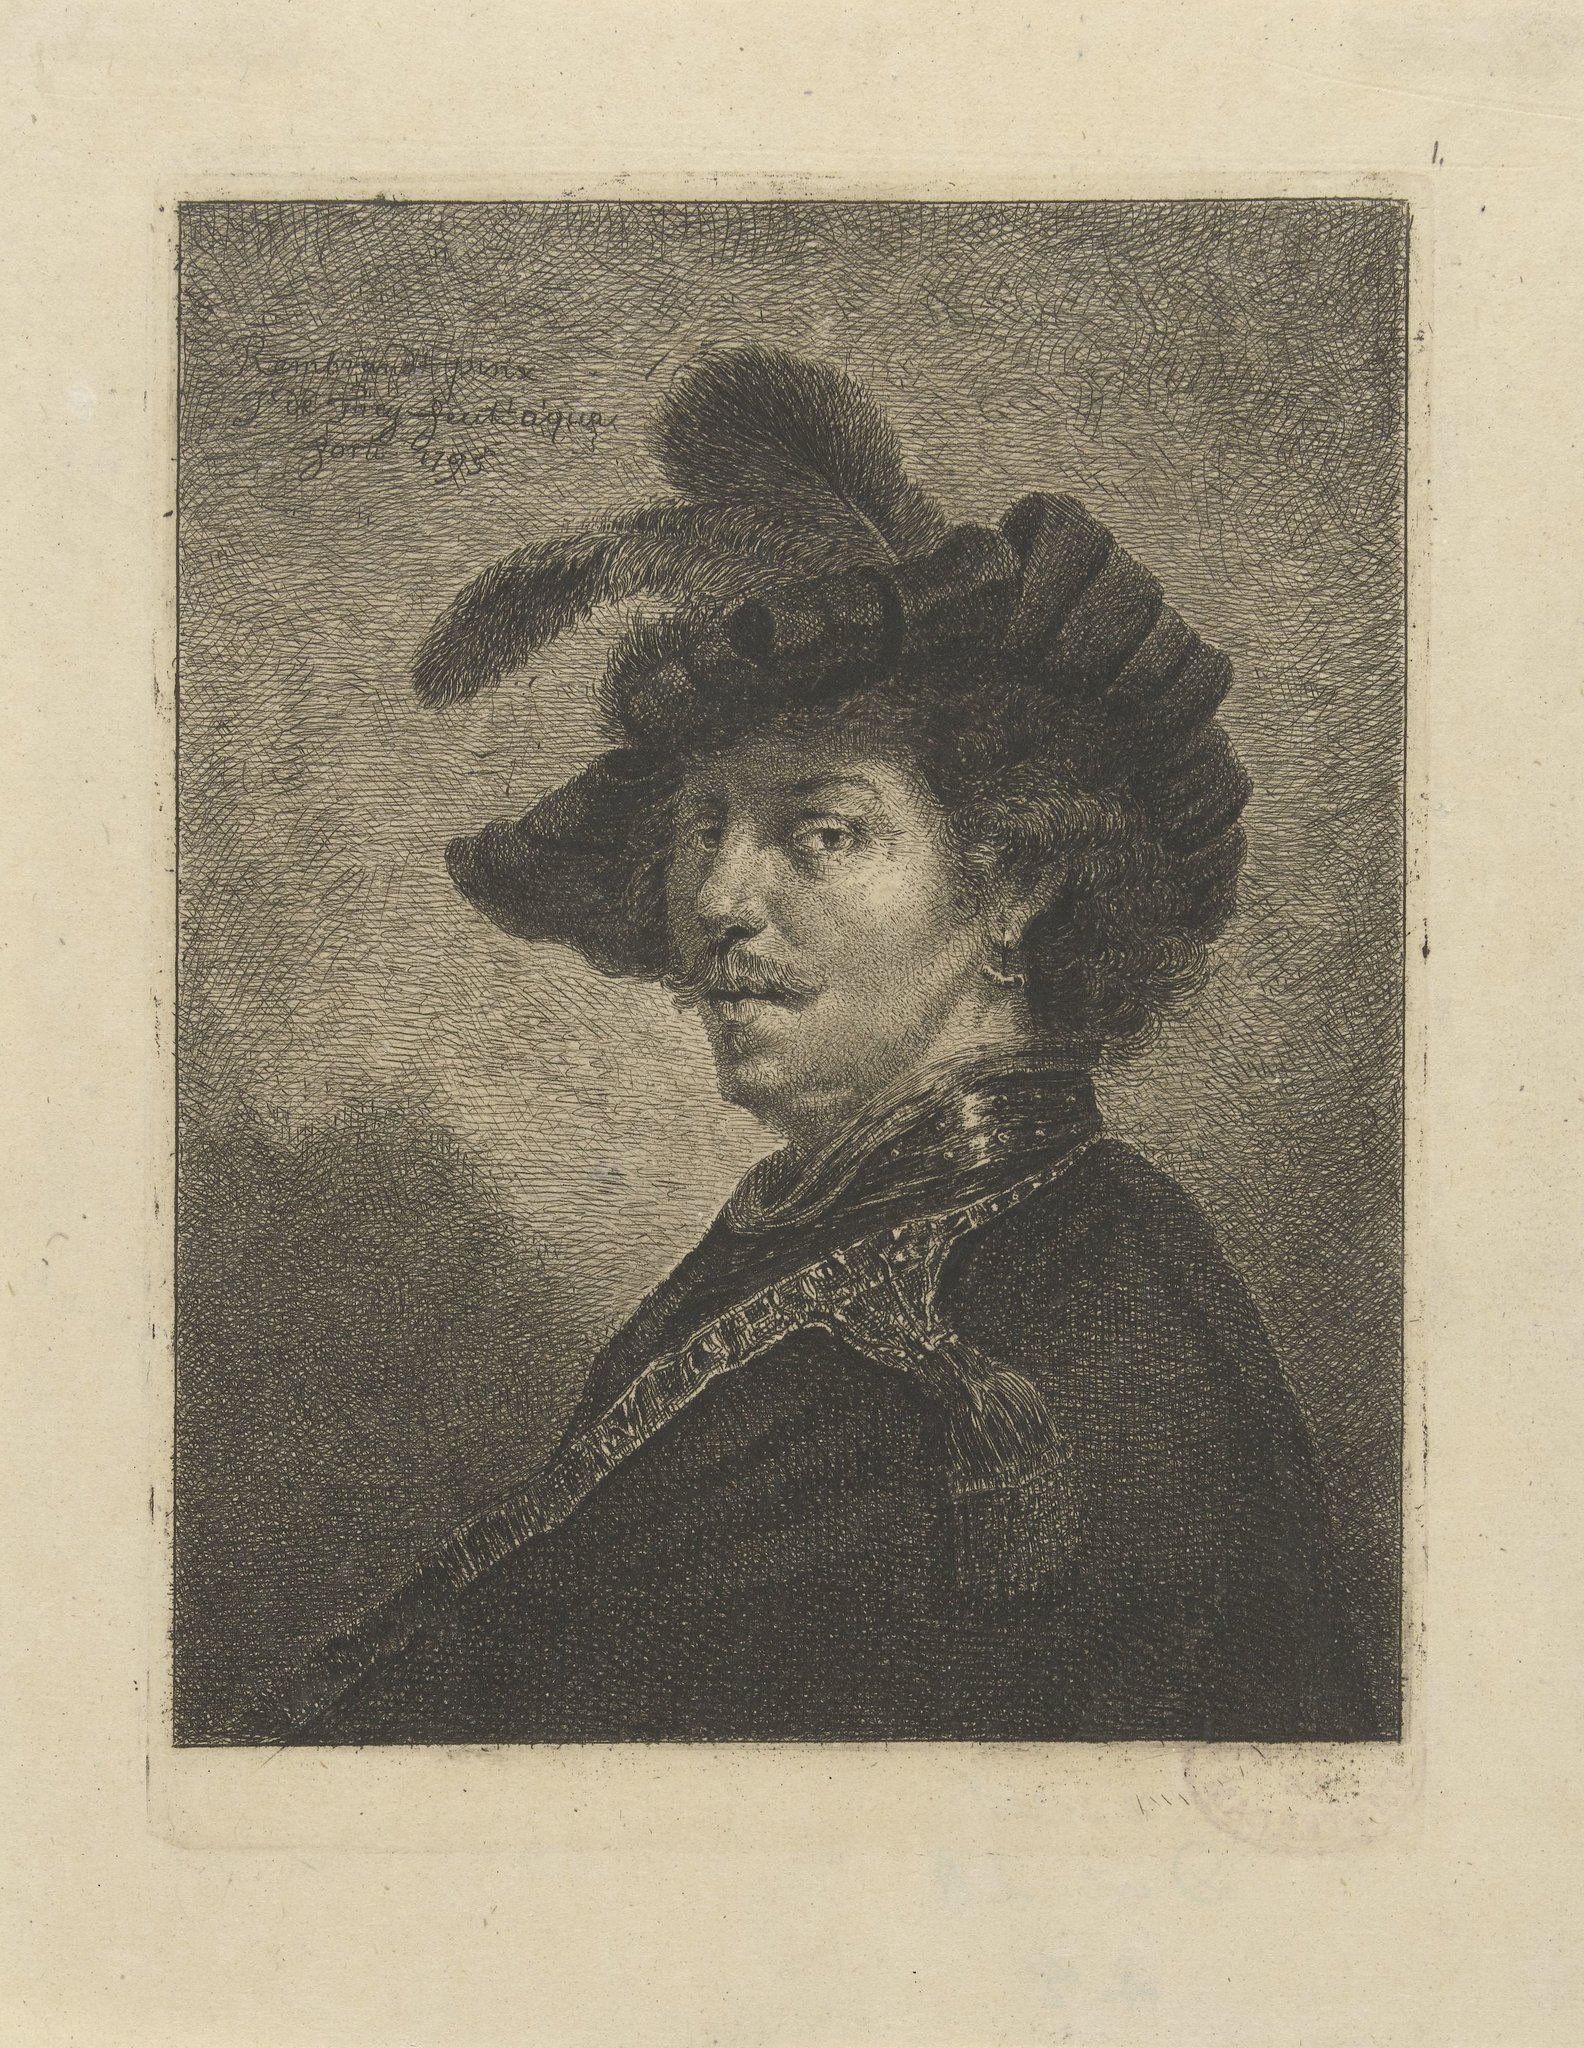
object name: print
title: Portret van een officier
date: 1795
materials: paper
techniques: etching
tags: portrait, self-portrait of artist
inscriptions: collector's mark: Lugt 12, number: ‘1’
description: Portret van een officier (mogelijk Rembrandt), ten halven lijve naar links. De platte hoed is getooid met twee veren.